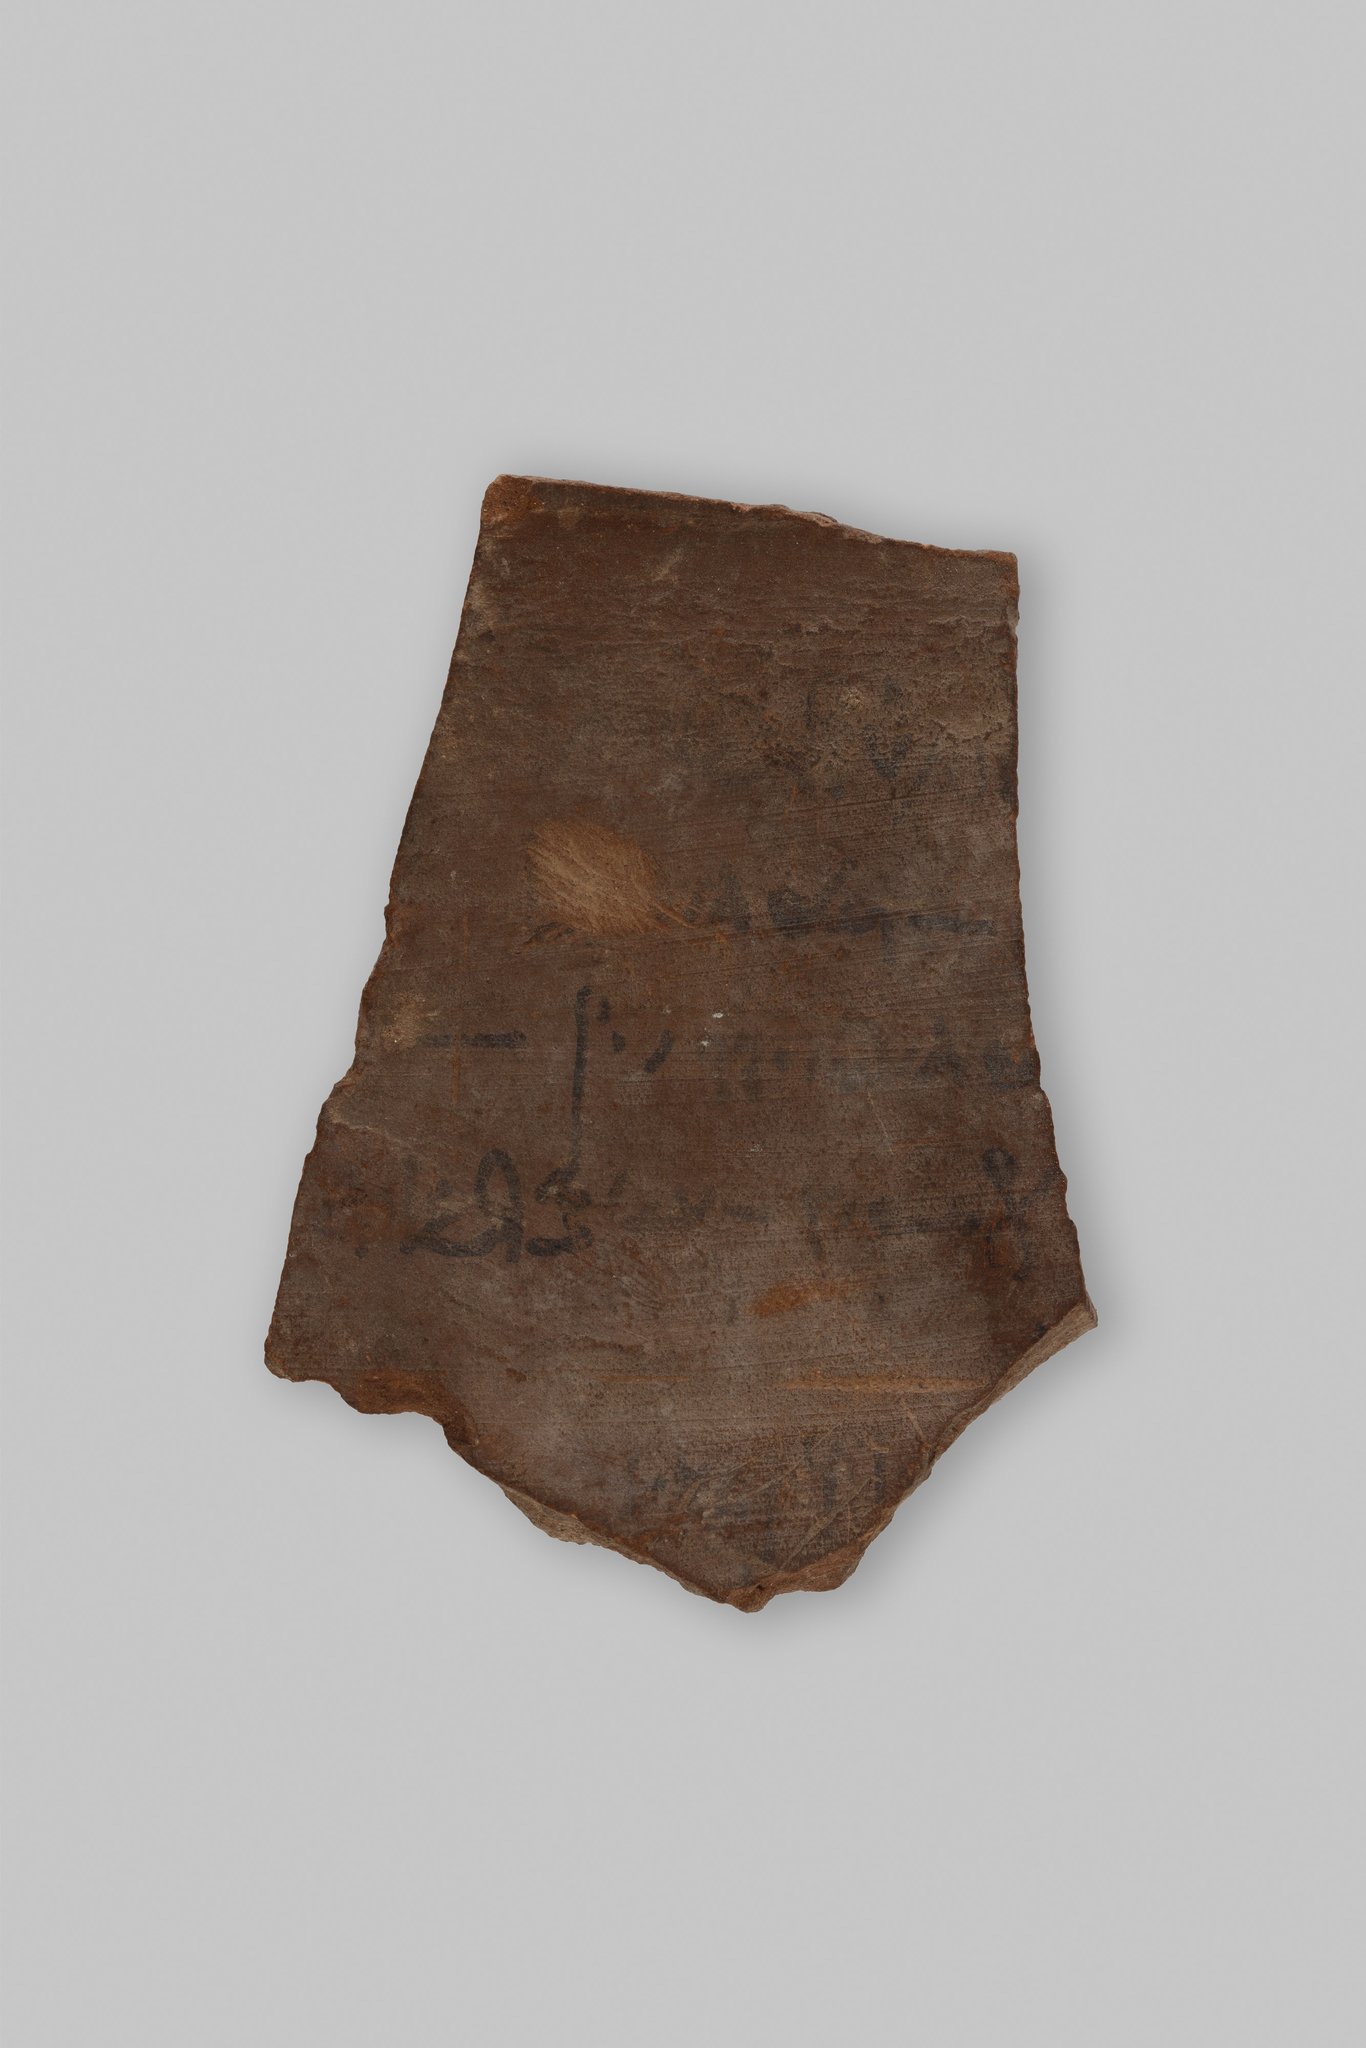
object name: ostracon, demotic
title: Ostracon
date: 600-30 BCE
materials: ink, pottery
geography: egypt